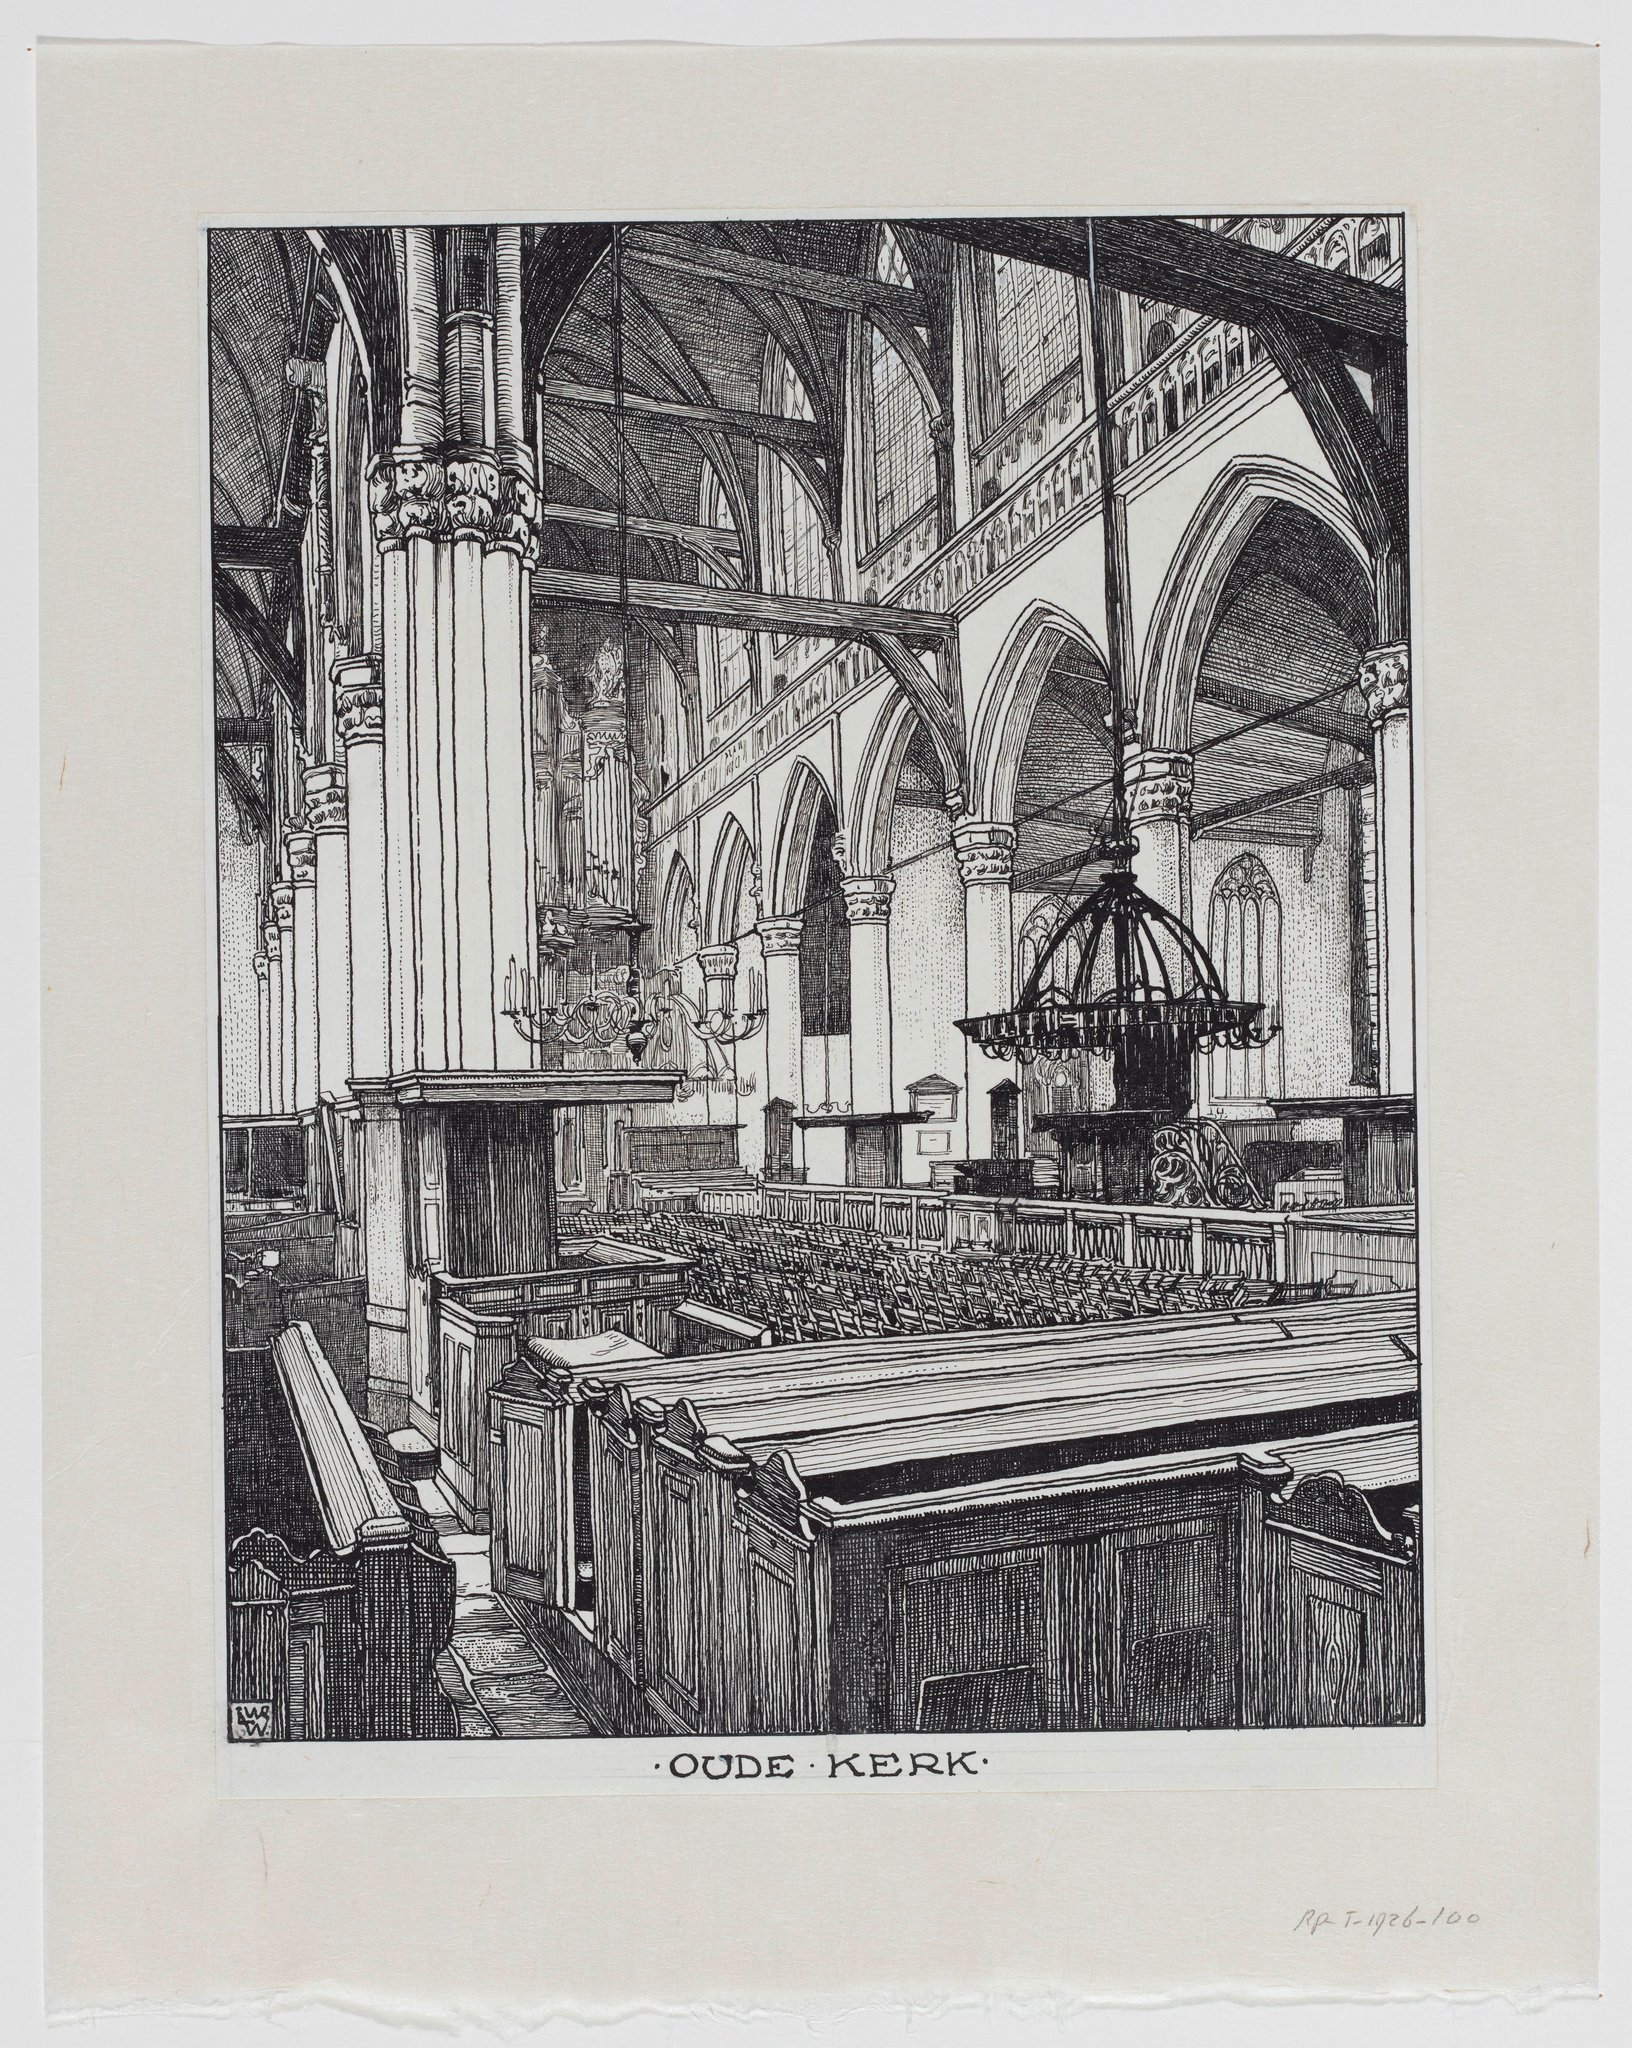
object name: drawing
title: Interieur van de Oude Kerk te Amsterdam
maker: willem wenckebach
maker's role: designer, draughtsman, painter, print maker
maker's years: 1860-1937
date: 1870-1926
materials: paint, ink, paper, pencil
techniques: pen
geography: amsterdam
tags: interior of church